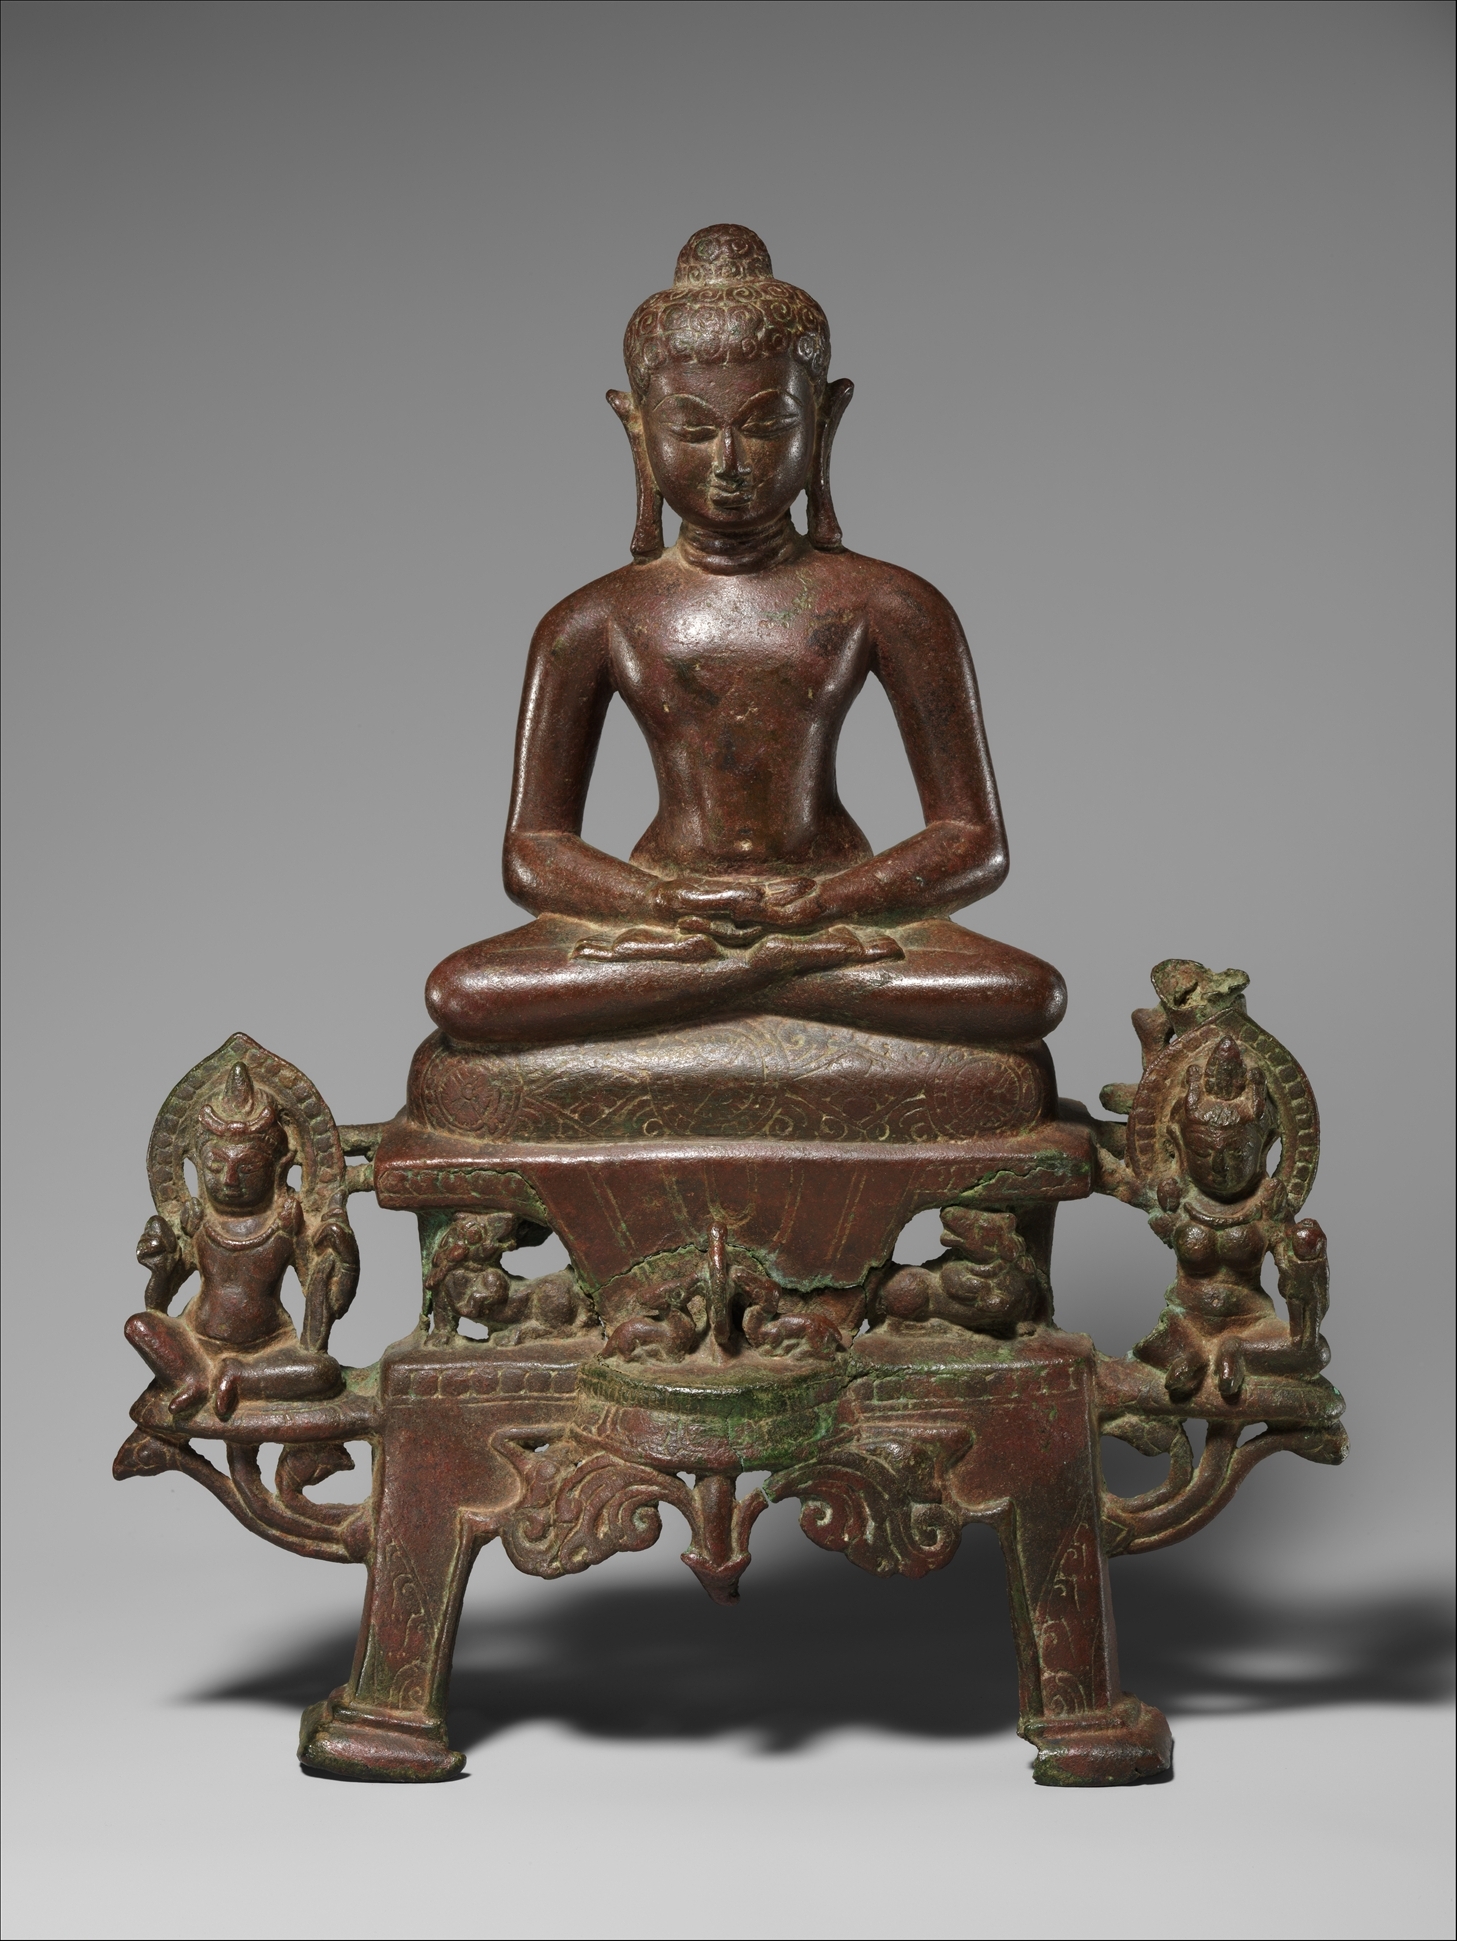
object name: figure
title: Enthroned Jina, Probably Neminatha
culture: indian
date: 667-700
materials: copper alloy